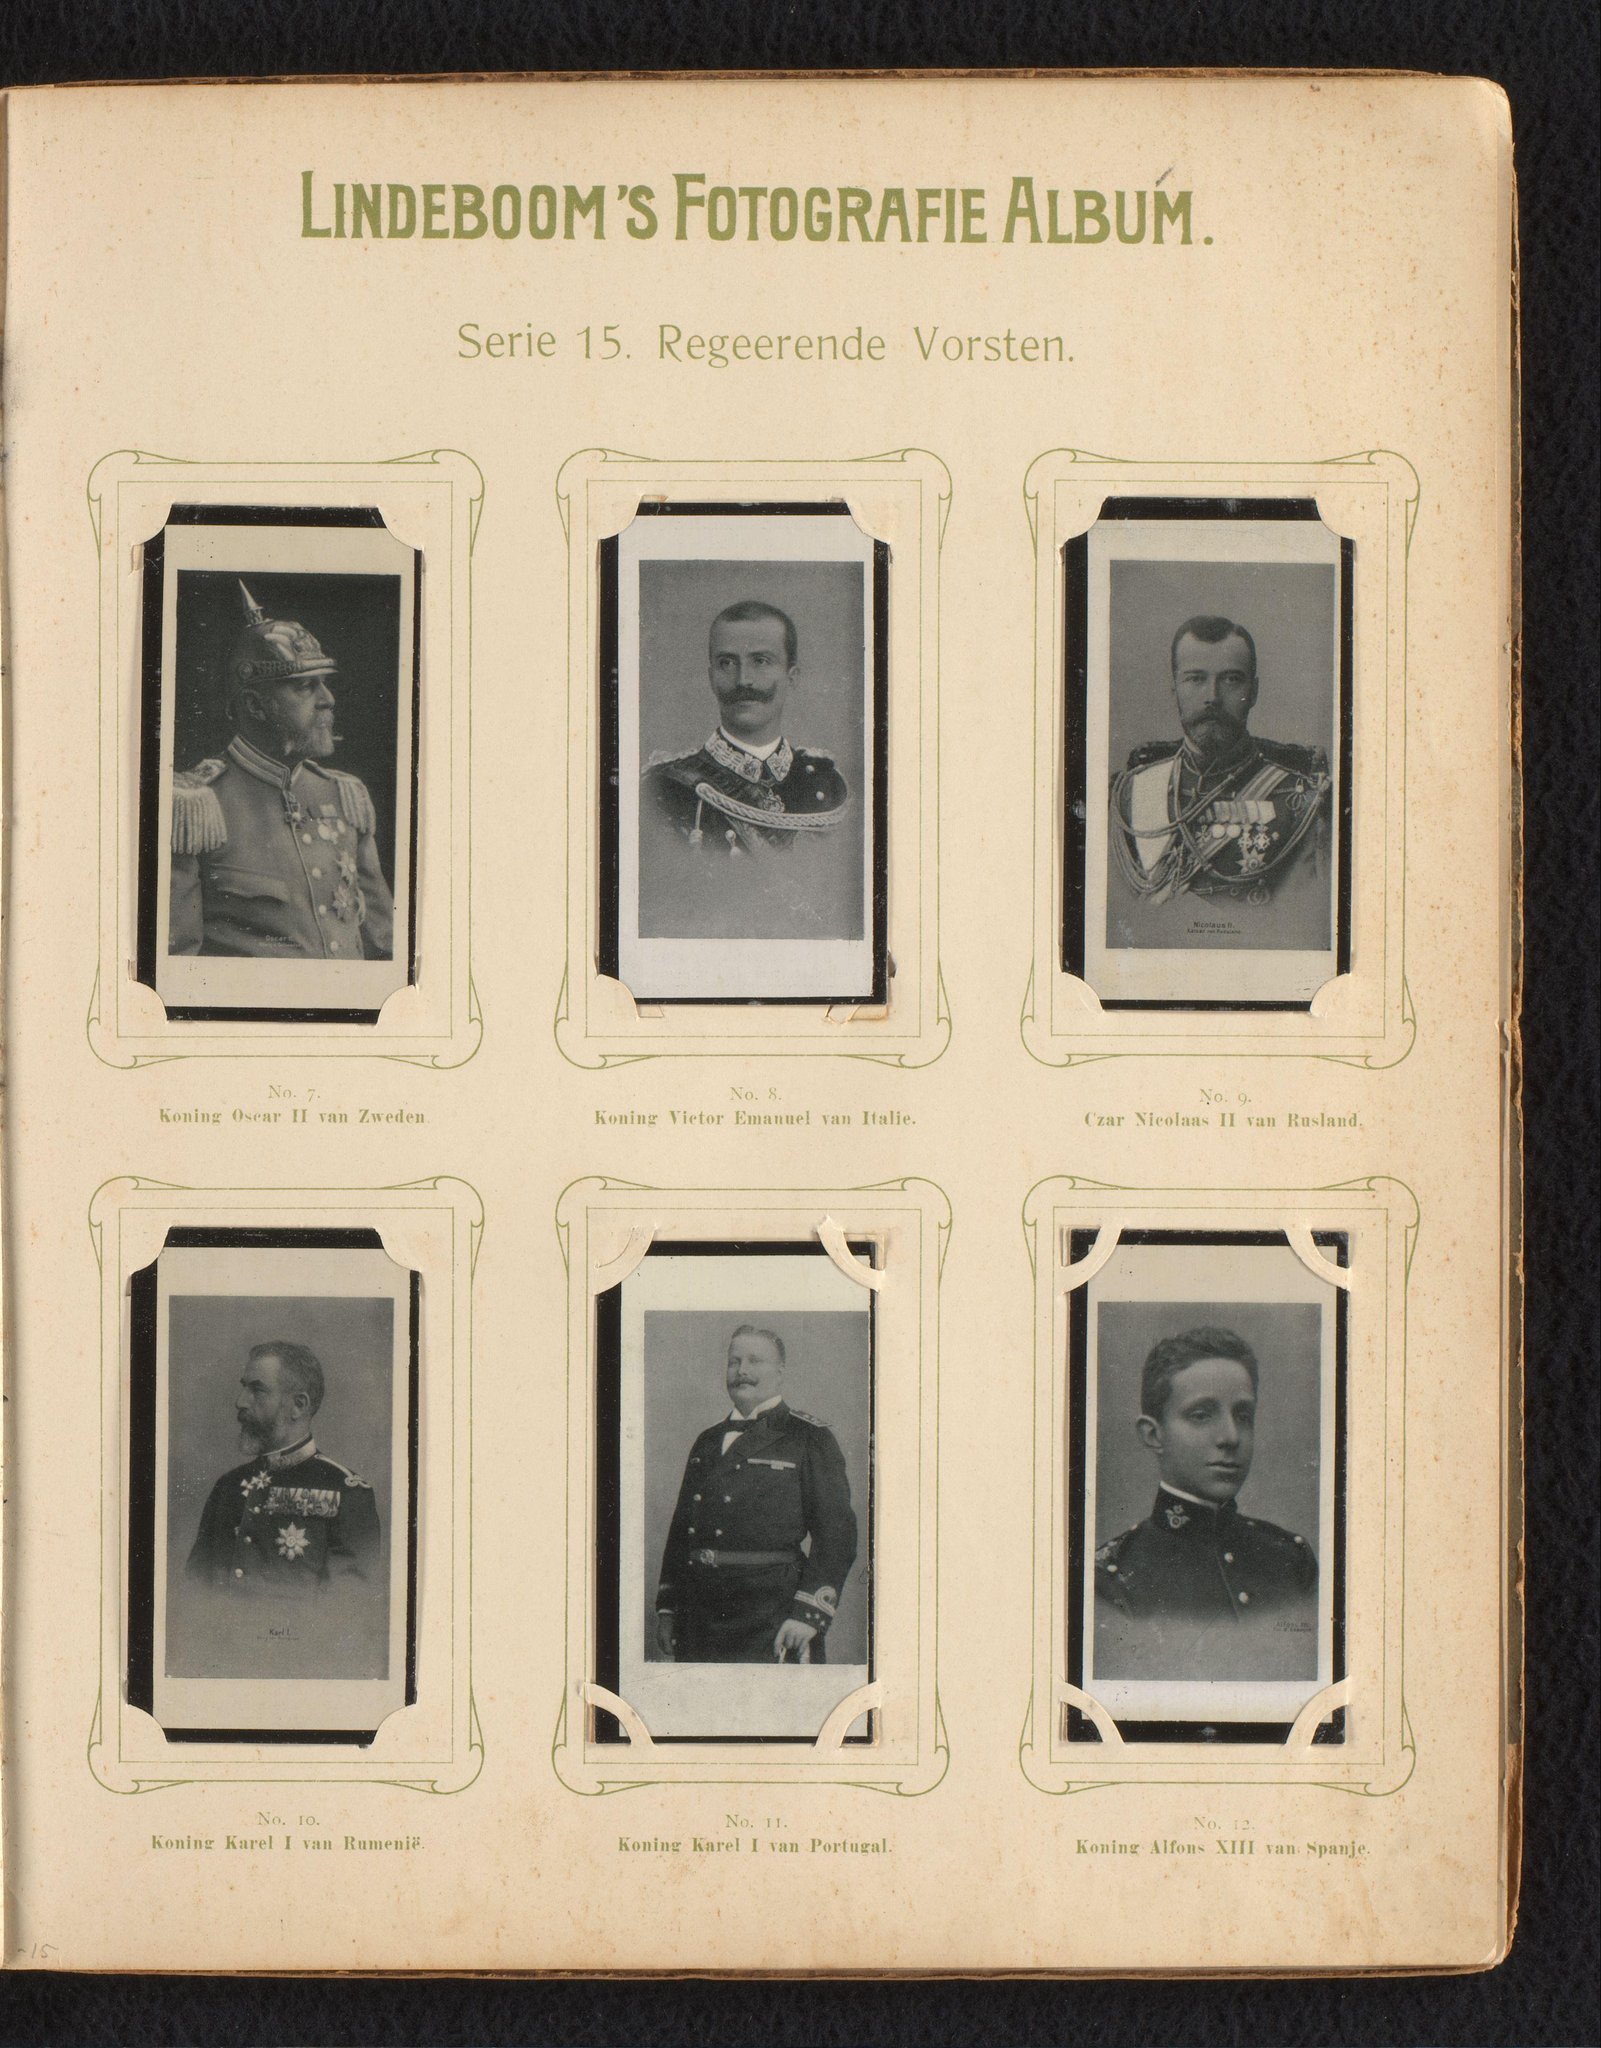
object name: reproduction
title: Regeerende vorsten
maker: Anonymous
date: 1905-1906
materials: cardboard, paper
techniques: photograph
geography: amsterdam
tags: historical persons, emperor, king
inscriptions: inscription: ‘Serie 15.’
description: Dergelijke prenten stonden bekend als 'zwartjes'. Men verkreeg ze bij aanschaf van bepaalde merken thee, cacao, sigaretten, beschuit, etc. om te verzamelen. Er waren speciaal voor de 'zwartjes' vervaardigde verzamelalbums in omloop.